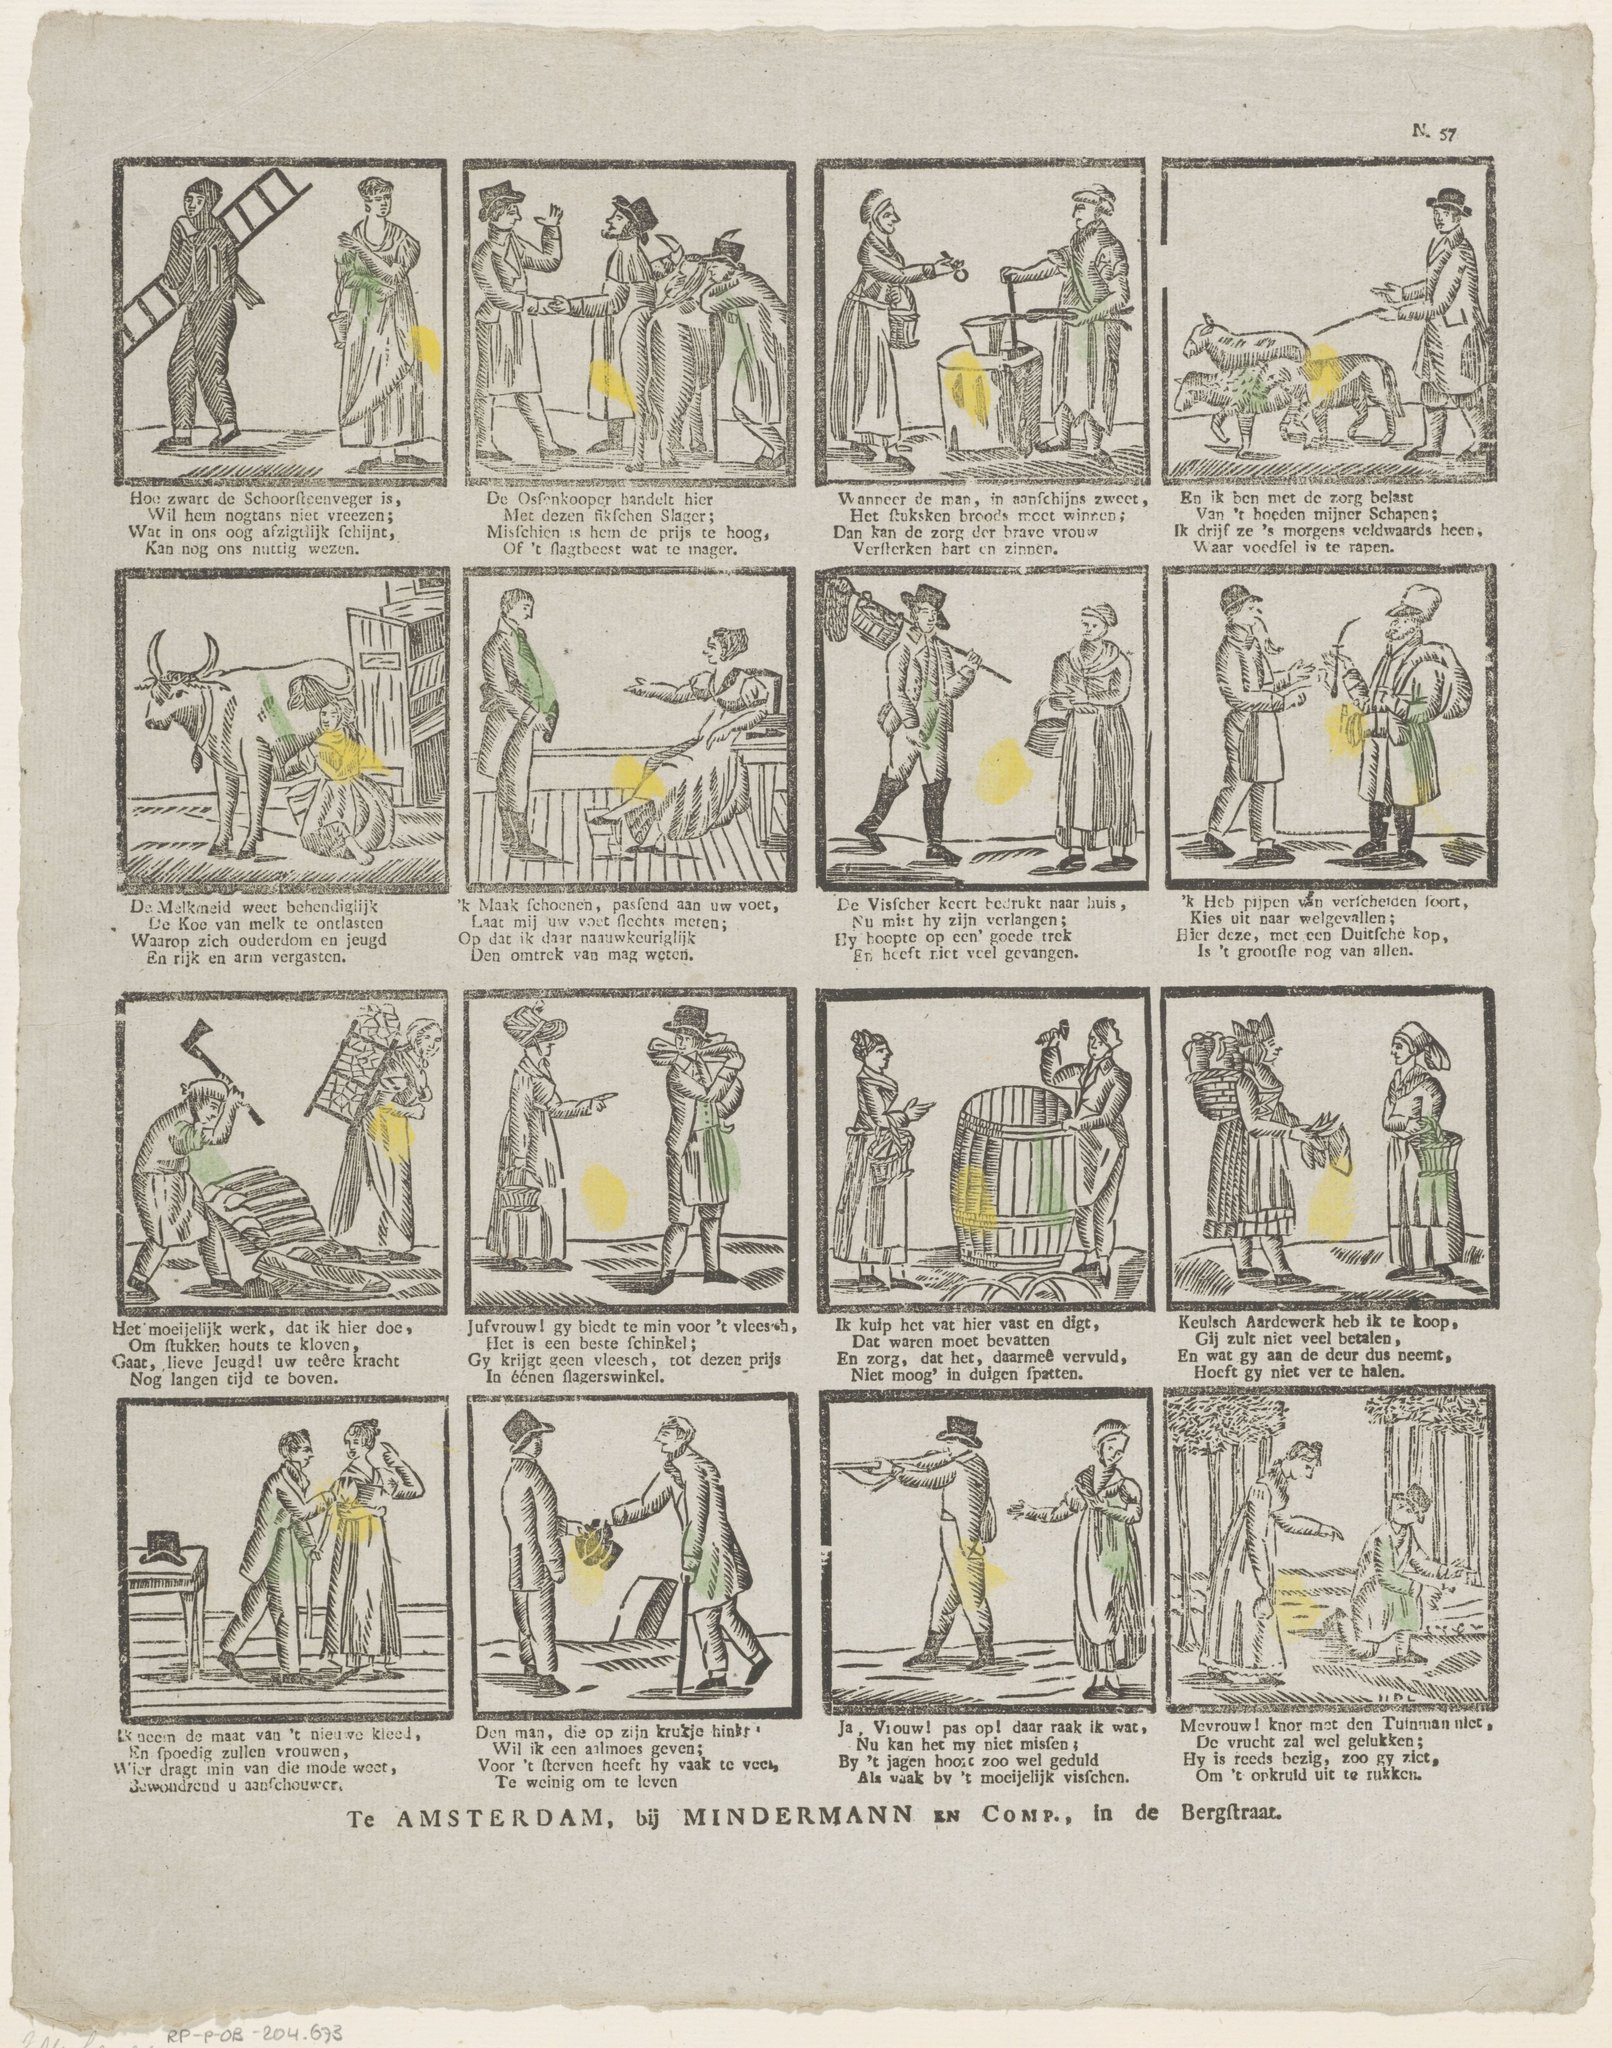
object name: popular print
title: Ambachten en beroepen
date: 1822-1849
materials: paper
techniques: colour, letterpress printing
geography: amsterdam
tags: craft-production, skilled handiwork, farmers, milkmaid, crafts and industries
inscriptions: collector's mark: Lugt 2760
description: Blad met 16 voorstellingen van ambachtslieden en beroepen, zoals schoorsteenveger, melkmeid, schoenmaker en kleermaker. Onder elke voorstelling een vierregelig vers. Genummerd rechtsboven: N. 57.